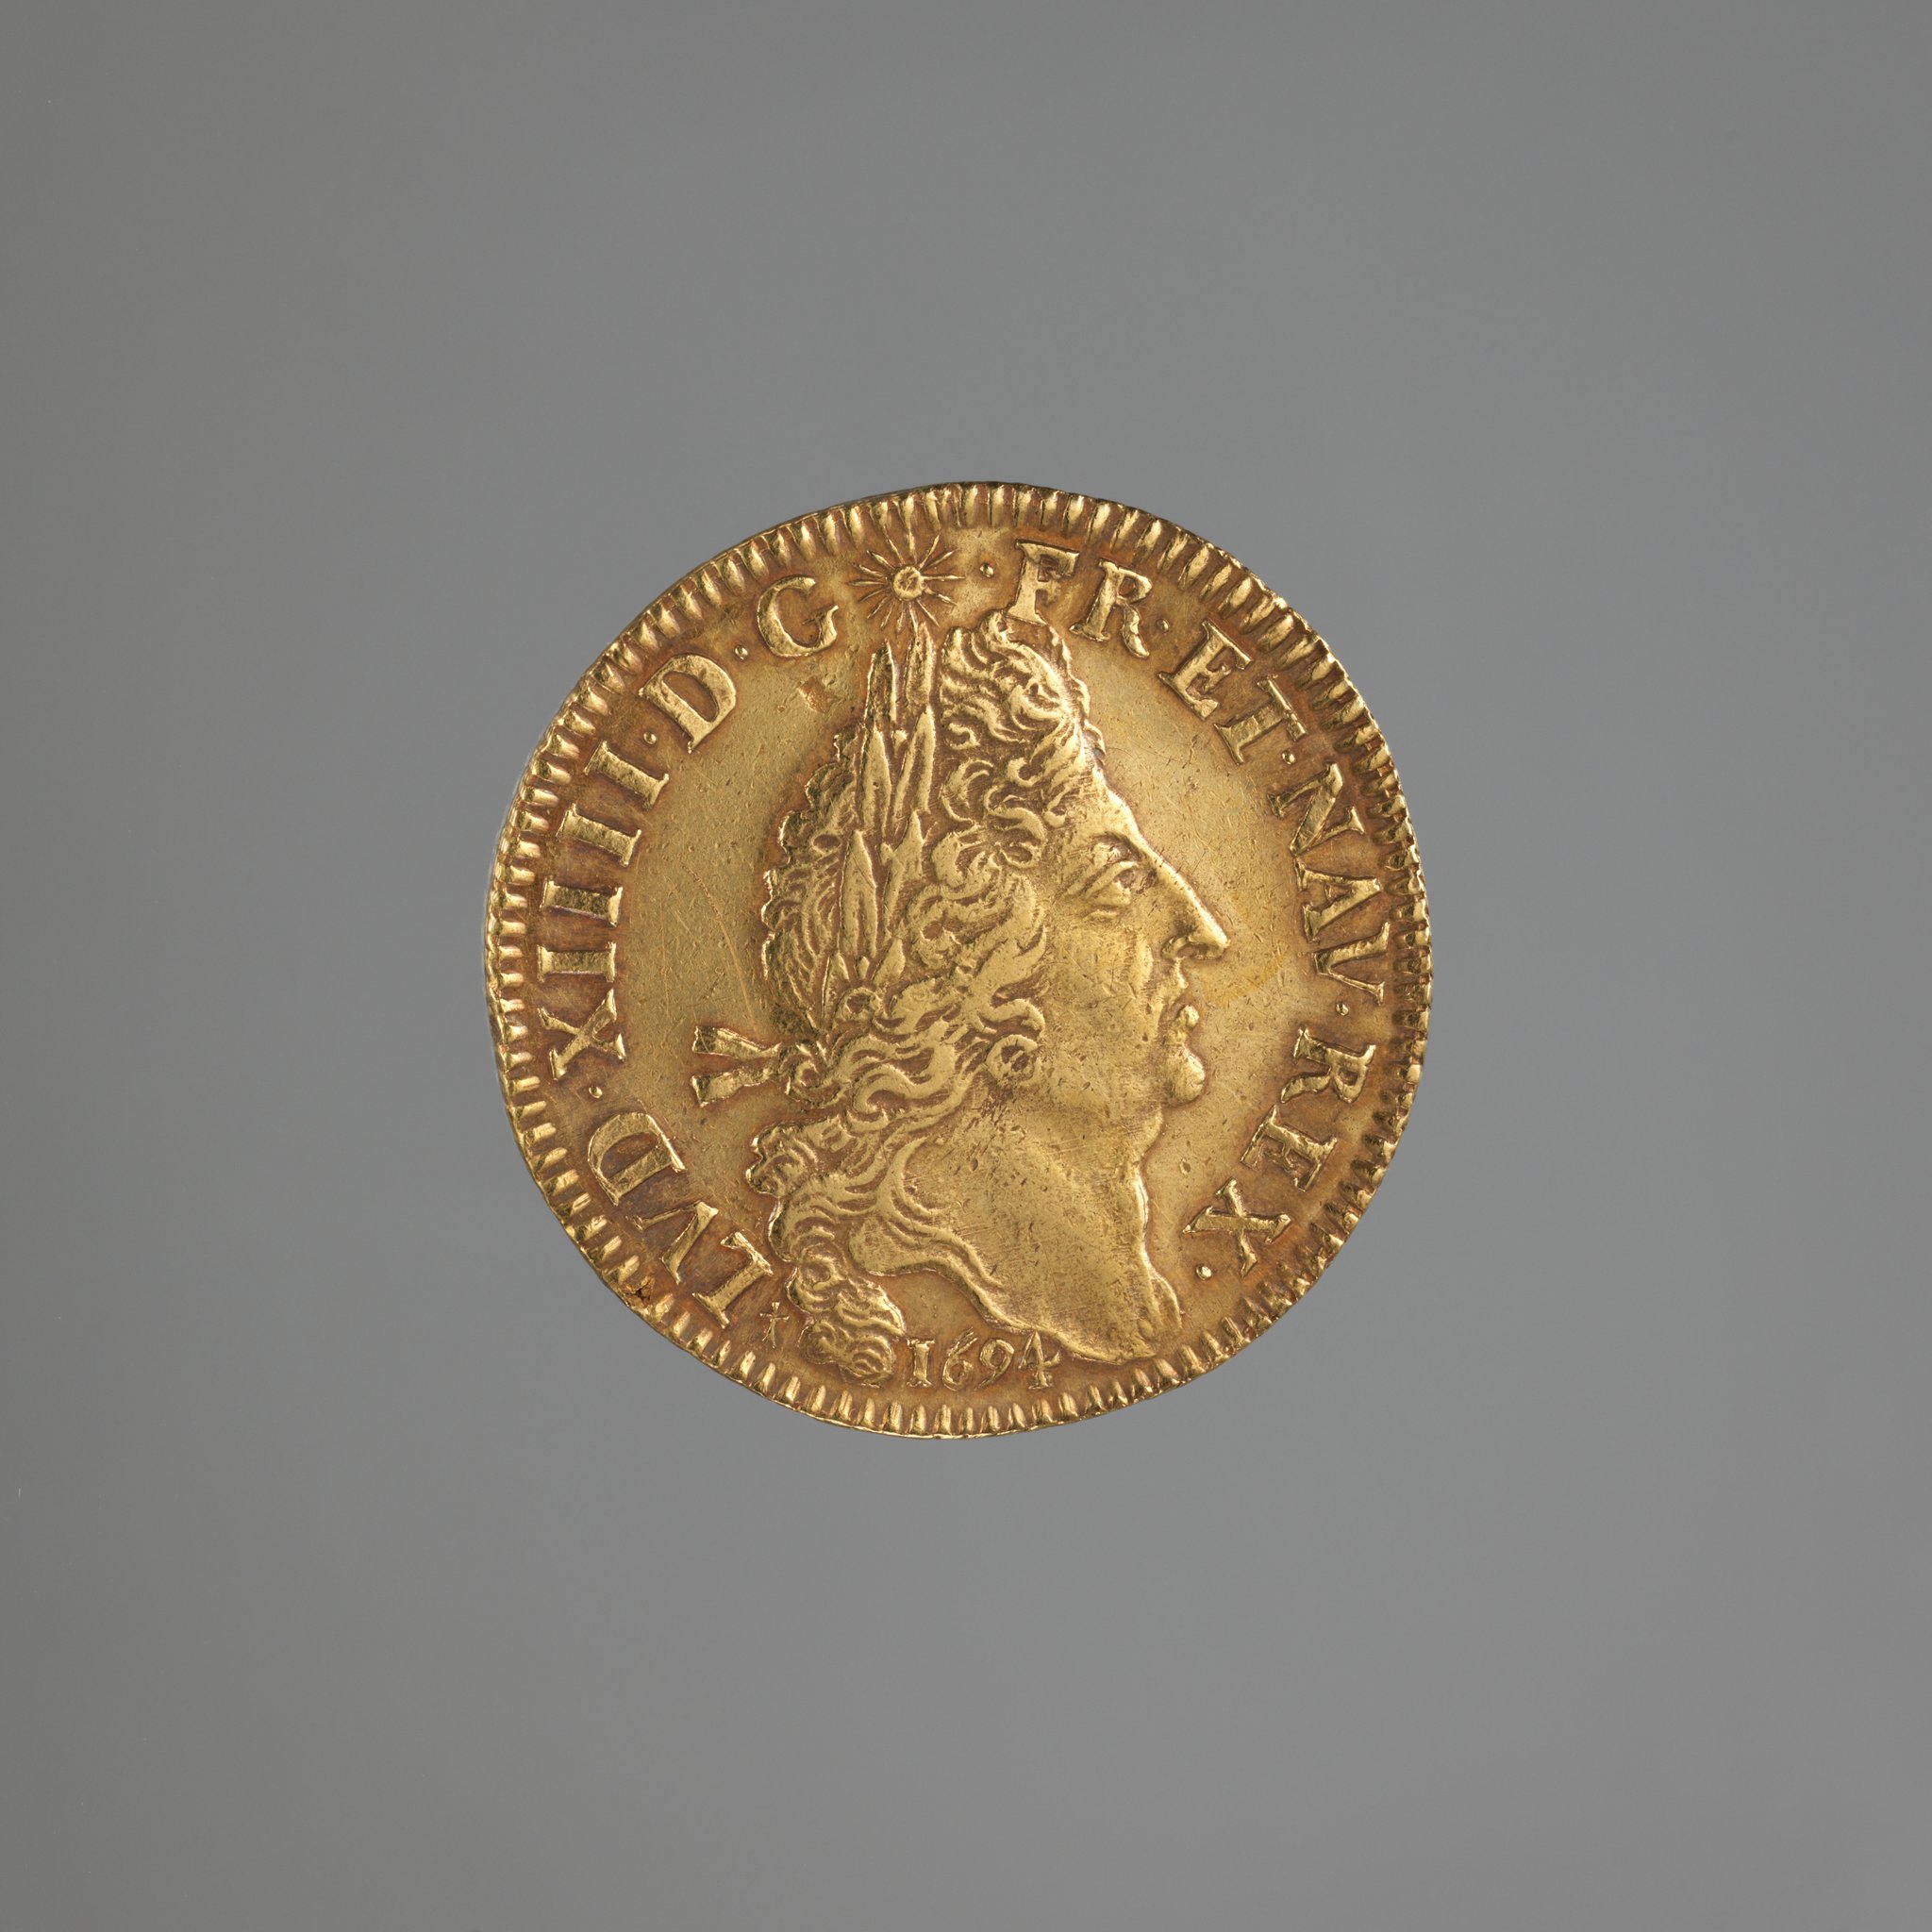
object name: coin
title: Double Louis d’or of Louis XIV of France (b.1638; r. 1643–1715)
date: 1694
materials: gold